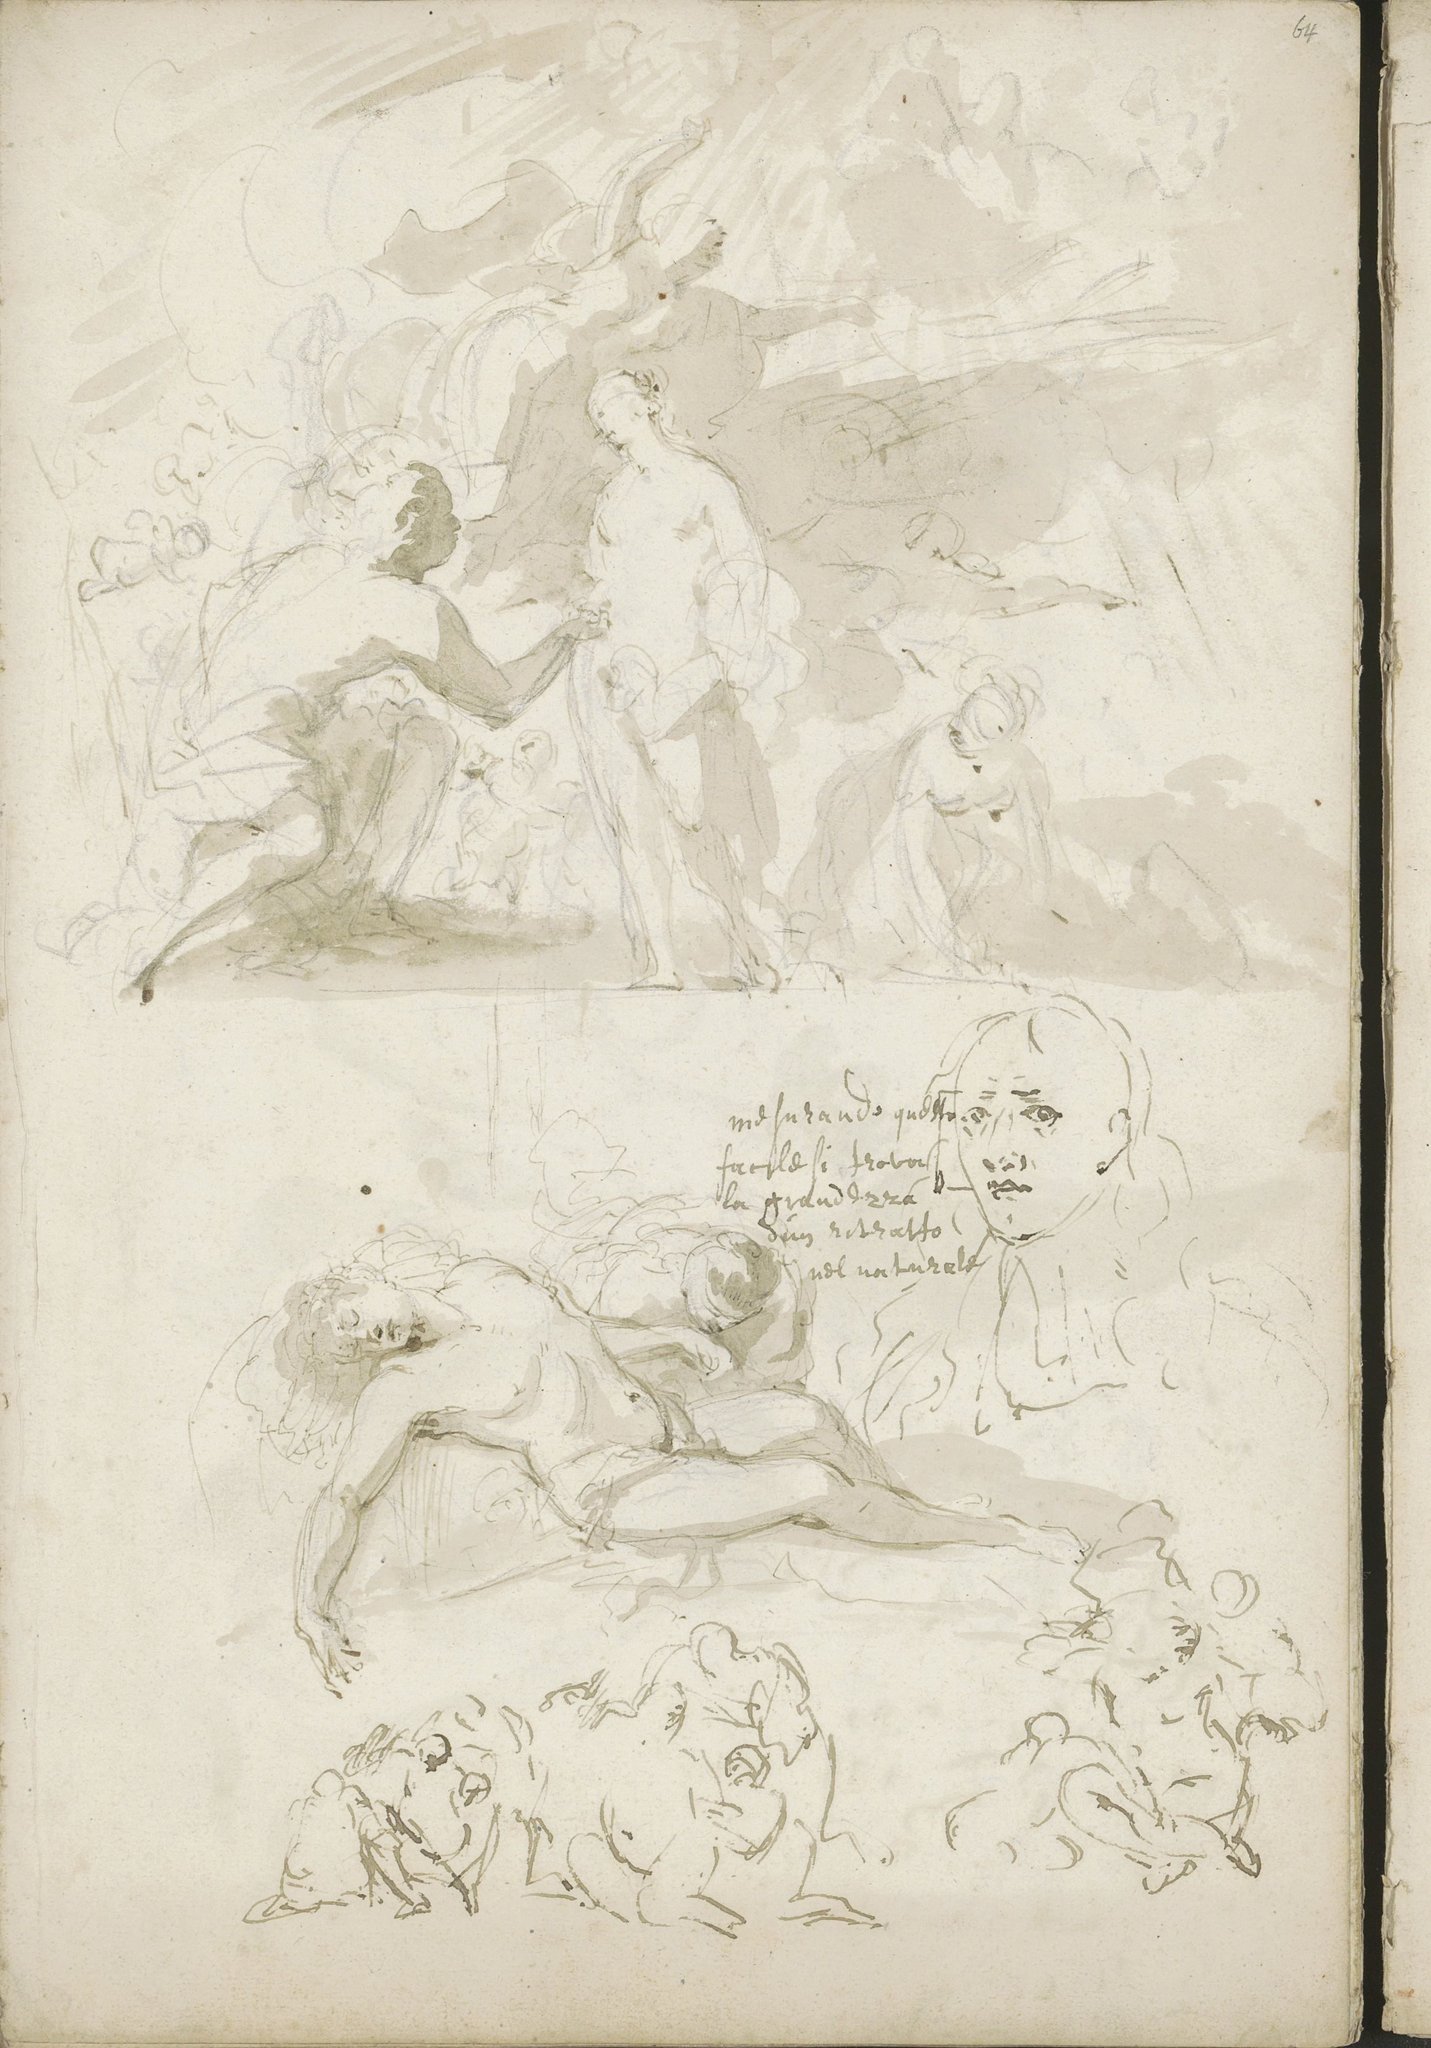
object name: sketchbook leaf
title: Studieblad met allegorische en mythologische voorstellingen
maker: Anonymous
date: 1650-1799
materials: ink, paper, pencil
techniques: brush, pen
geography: italy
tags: classical mythology and ancient history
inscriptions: annotation: ‘m[...]rande qud[...]/ fo[...]d fi frob[...]/ la grandezza/ di[...] ritratto/ n[...] naturele’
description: Bladzijde 64 uit een schetsboek met 72 bladzijden.